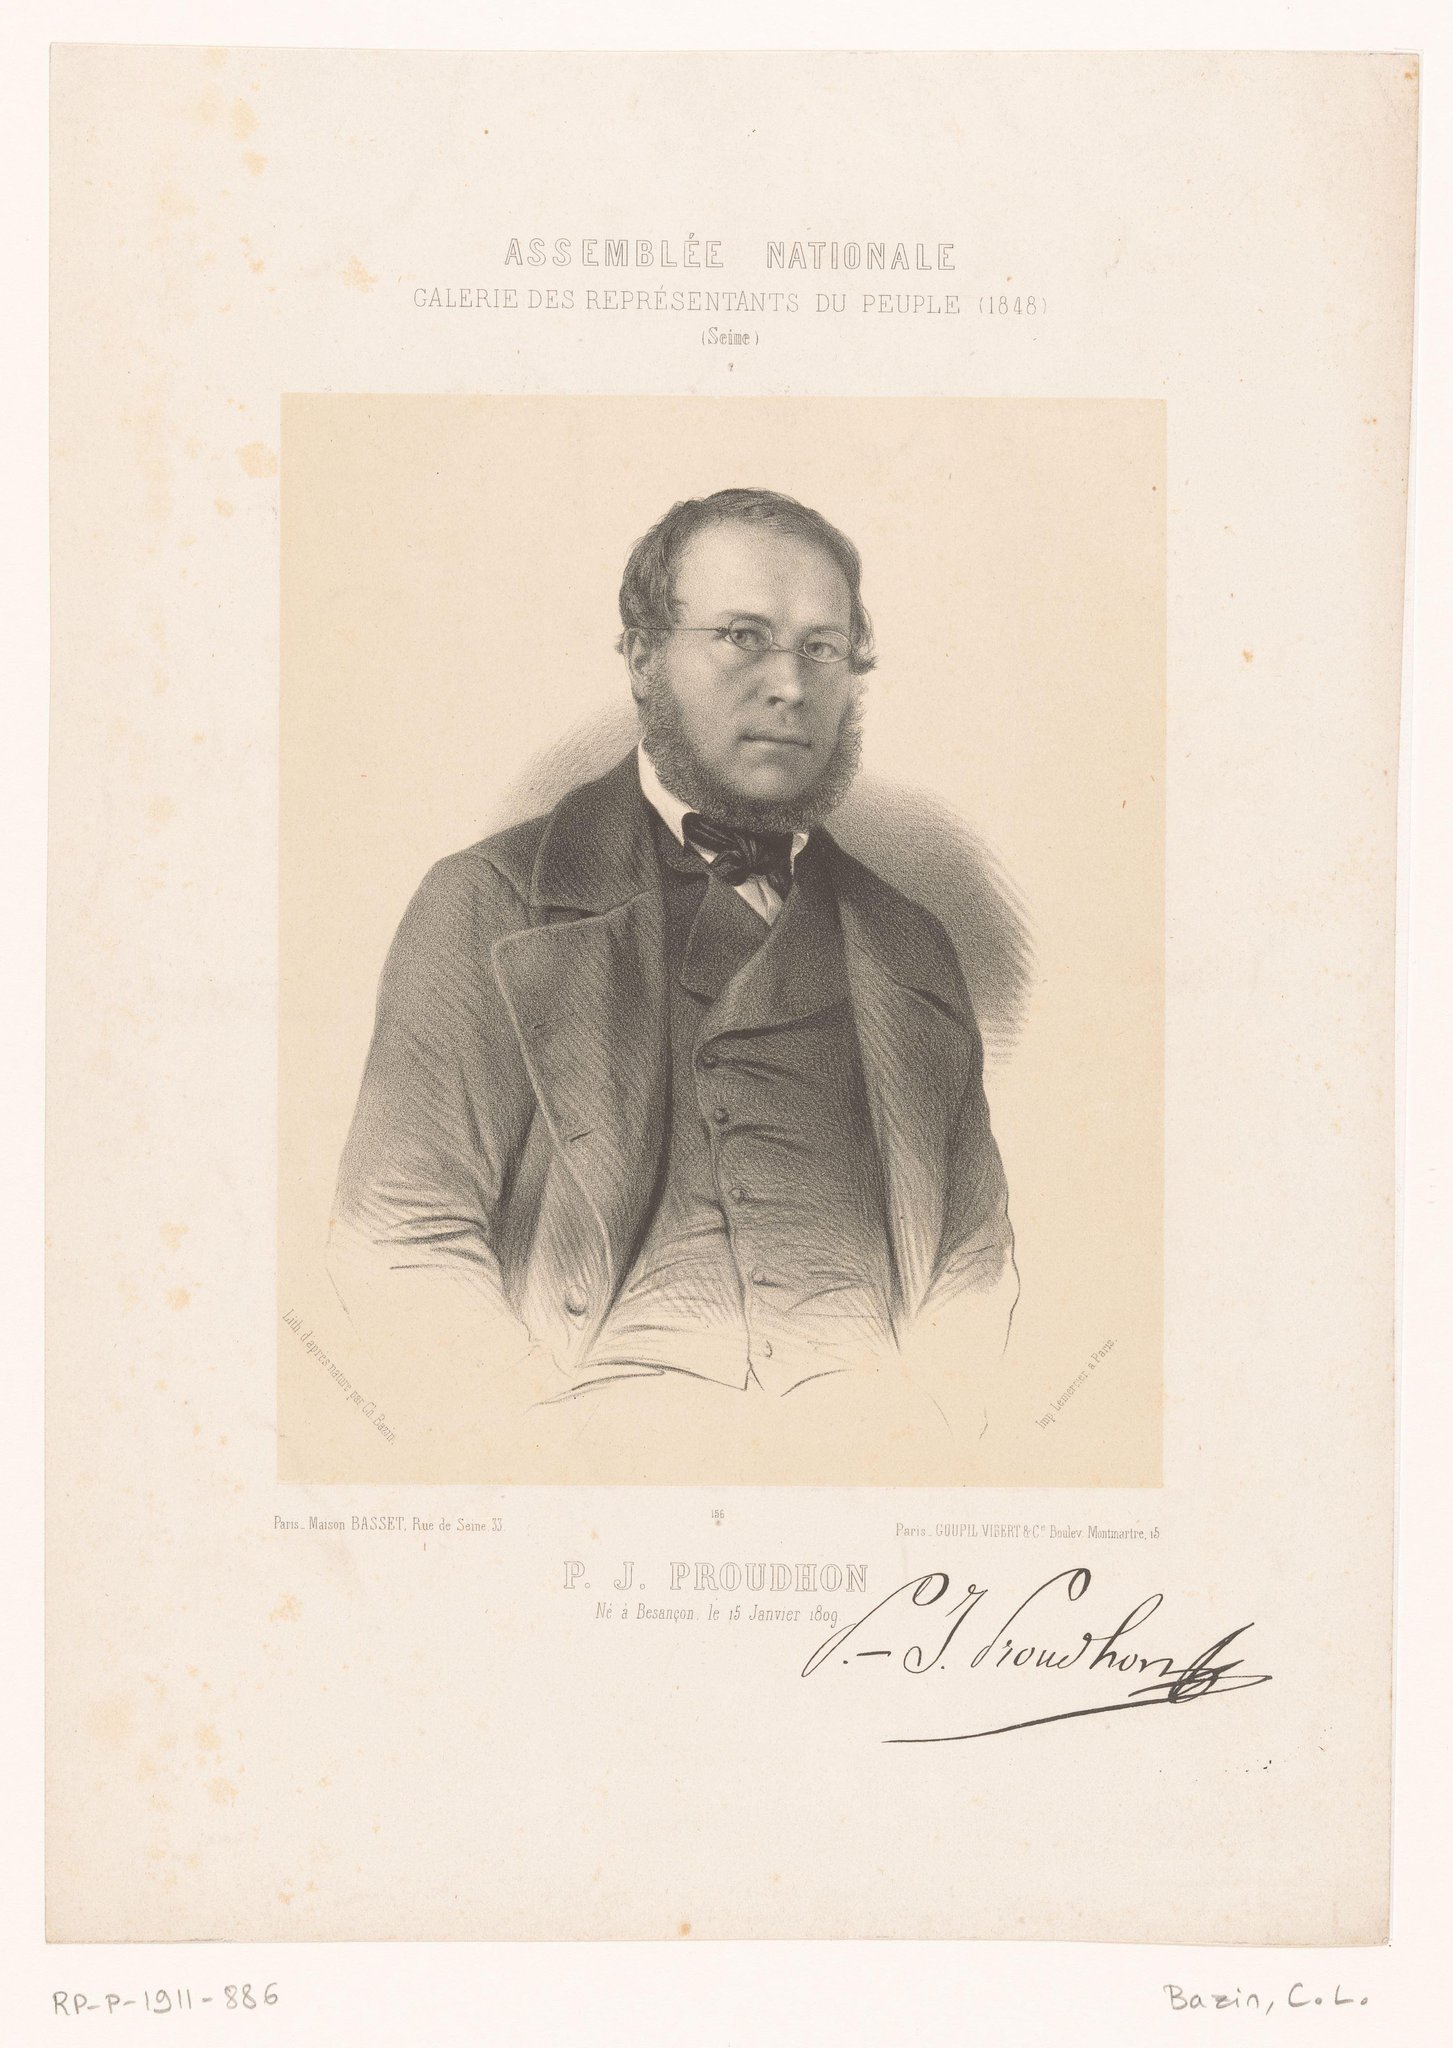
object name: print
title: P.J. Proudhon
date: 1848-1849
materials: paper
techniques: lithograph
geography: paris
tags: paris, historical persons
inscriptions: collector's mark: Lugt 2228a, number: ‘6238’